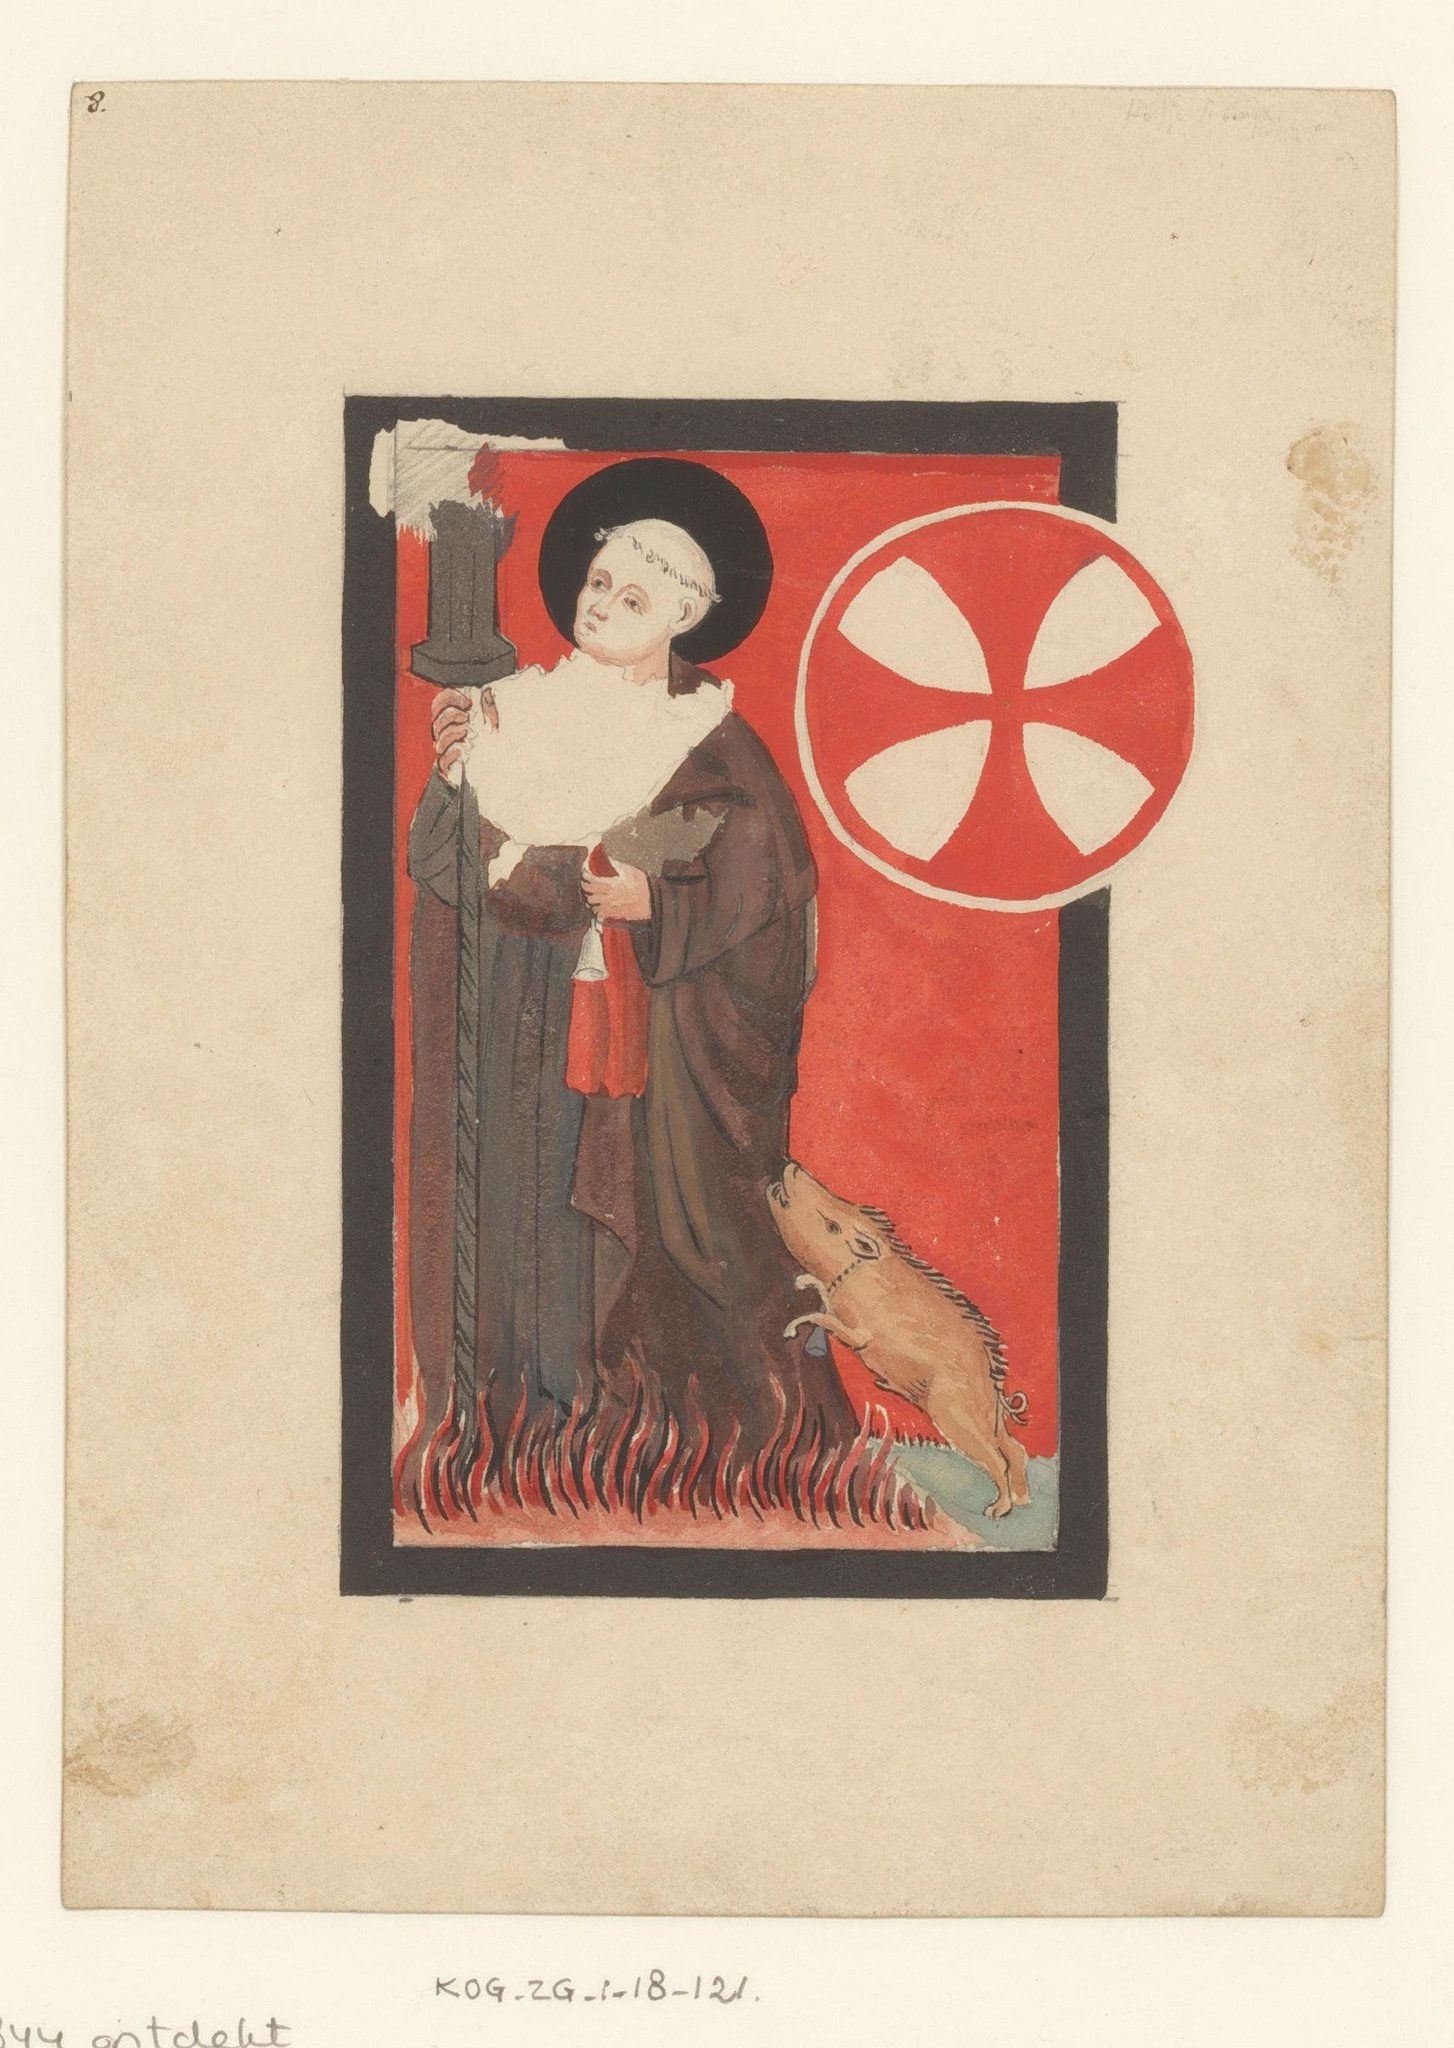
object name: drawing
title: Antonius van Egypte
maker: tiemen hooiberg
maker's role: painter, print maker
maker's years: 1809-1897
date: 1844-1897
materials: ink, paper, watercolor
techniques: brush, pen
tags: saints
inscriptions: stamp, collector's mark: Lugt 1641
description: Antonius van Egypte staat in het vuur en met een zwijn. Linksboven genummerd: 6. Onderwerpsrubrieken binnen de Atlas Zeden en Gewoonten: Schoone kunsten, Muur- en gewelfschilderingen.